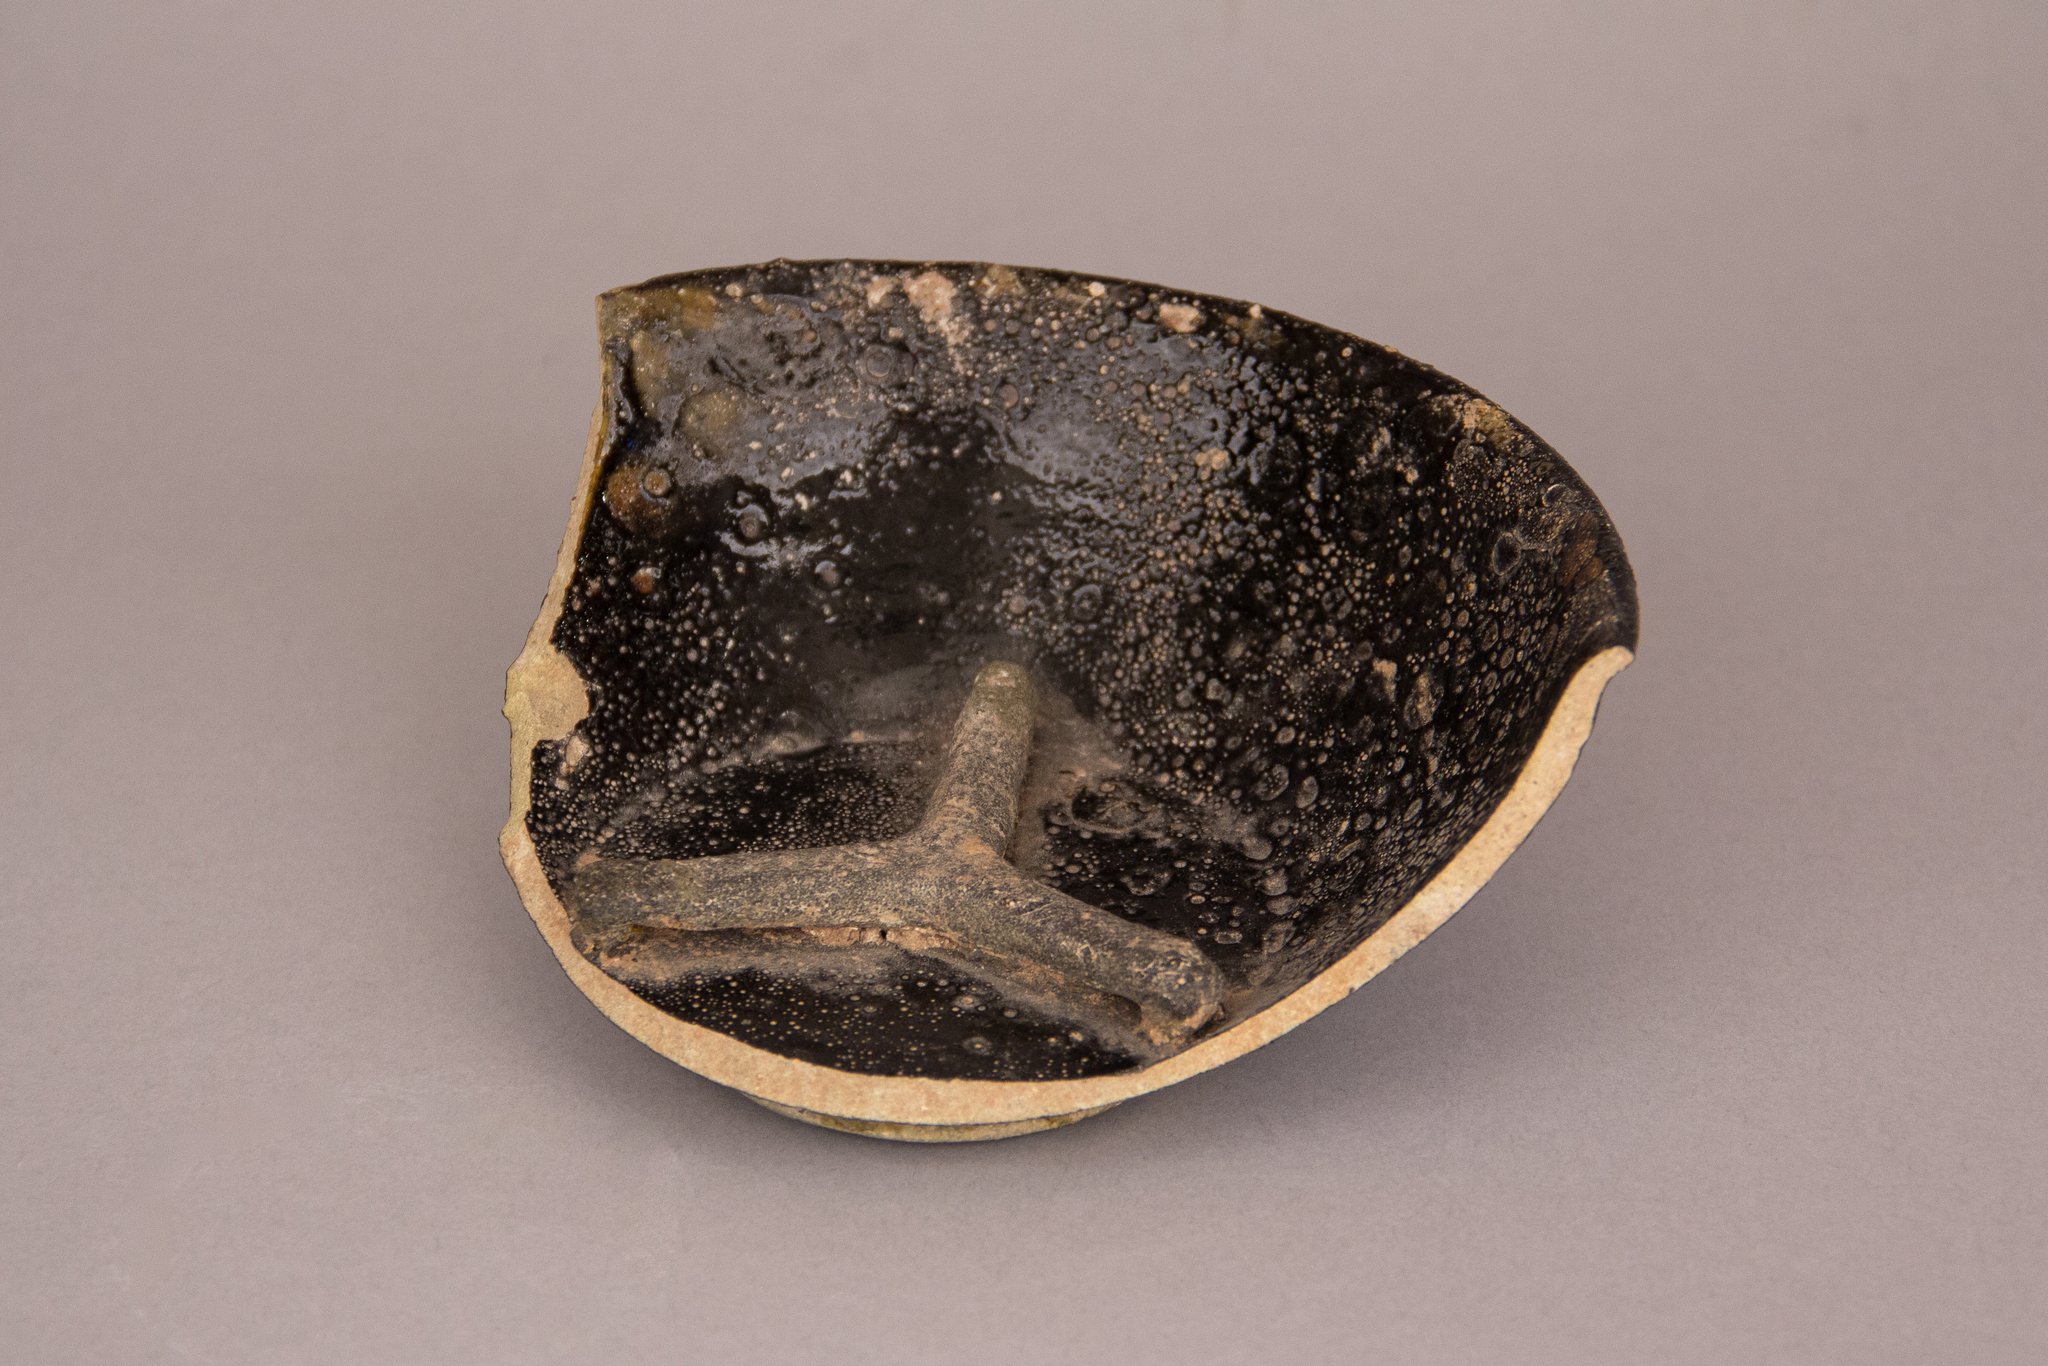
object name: waster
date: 1501-1700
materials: earthenware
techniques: glazing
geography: iran